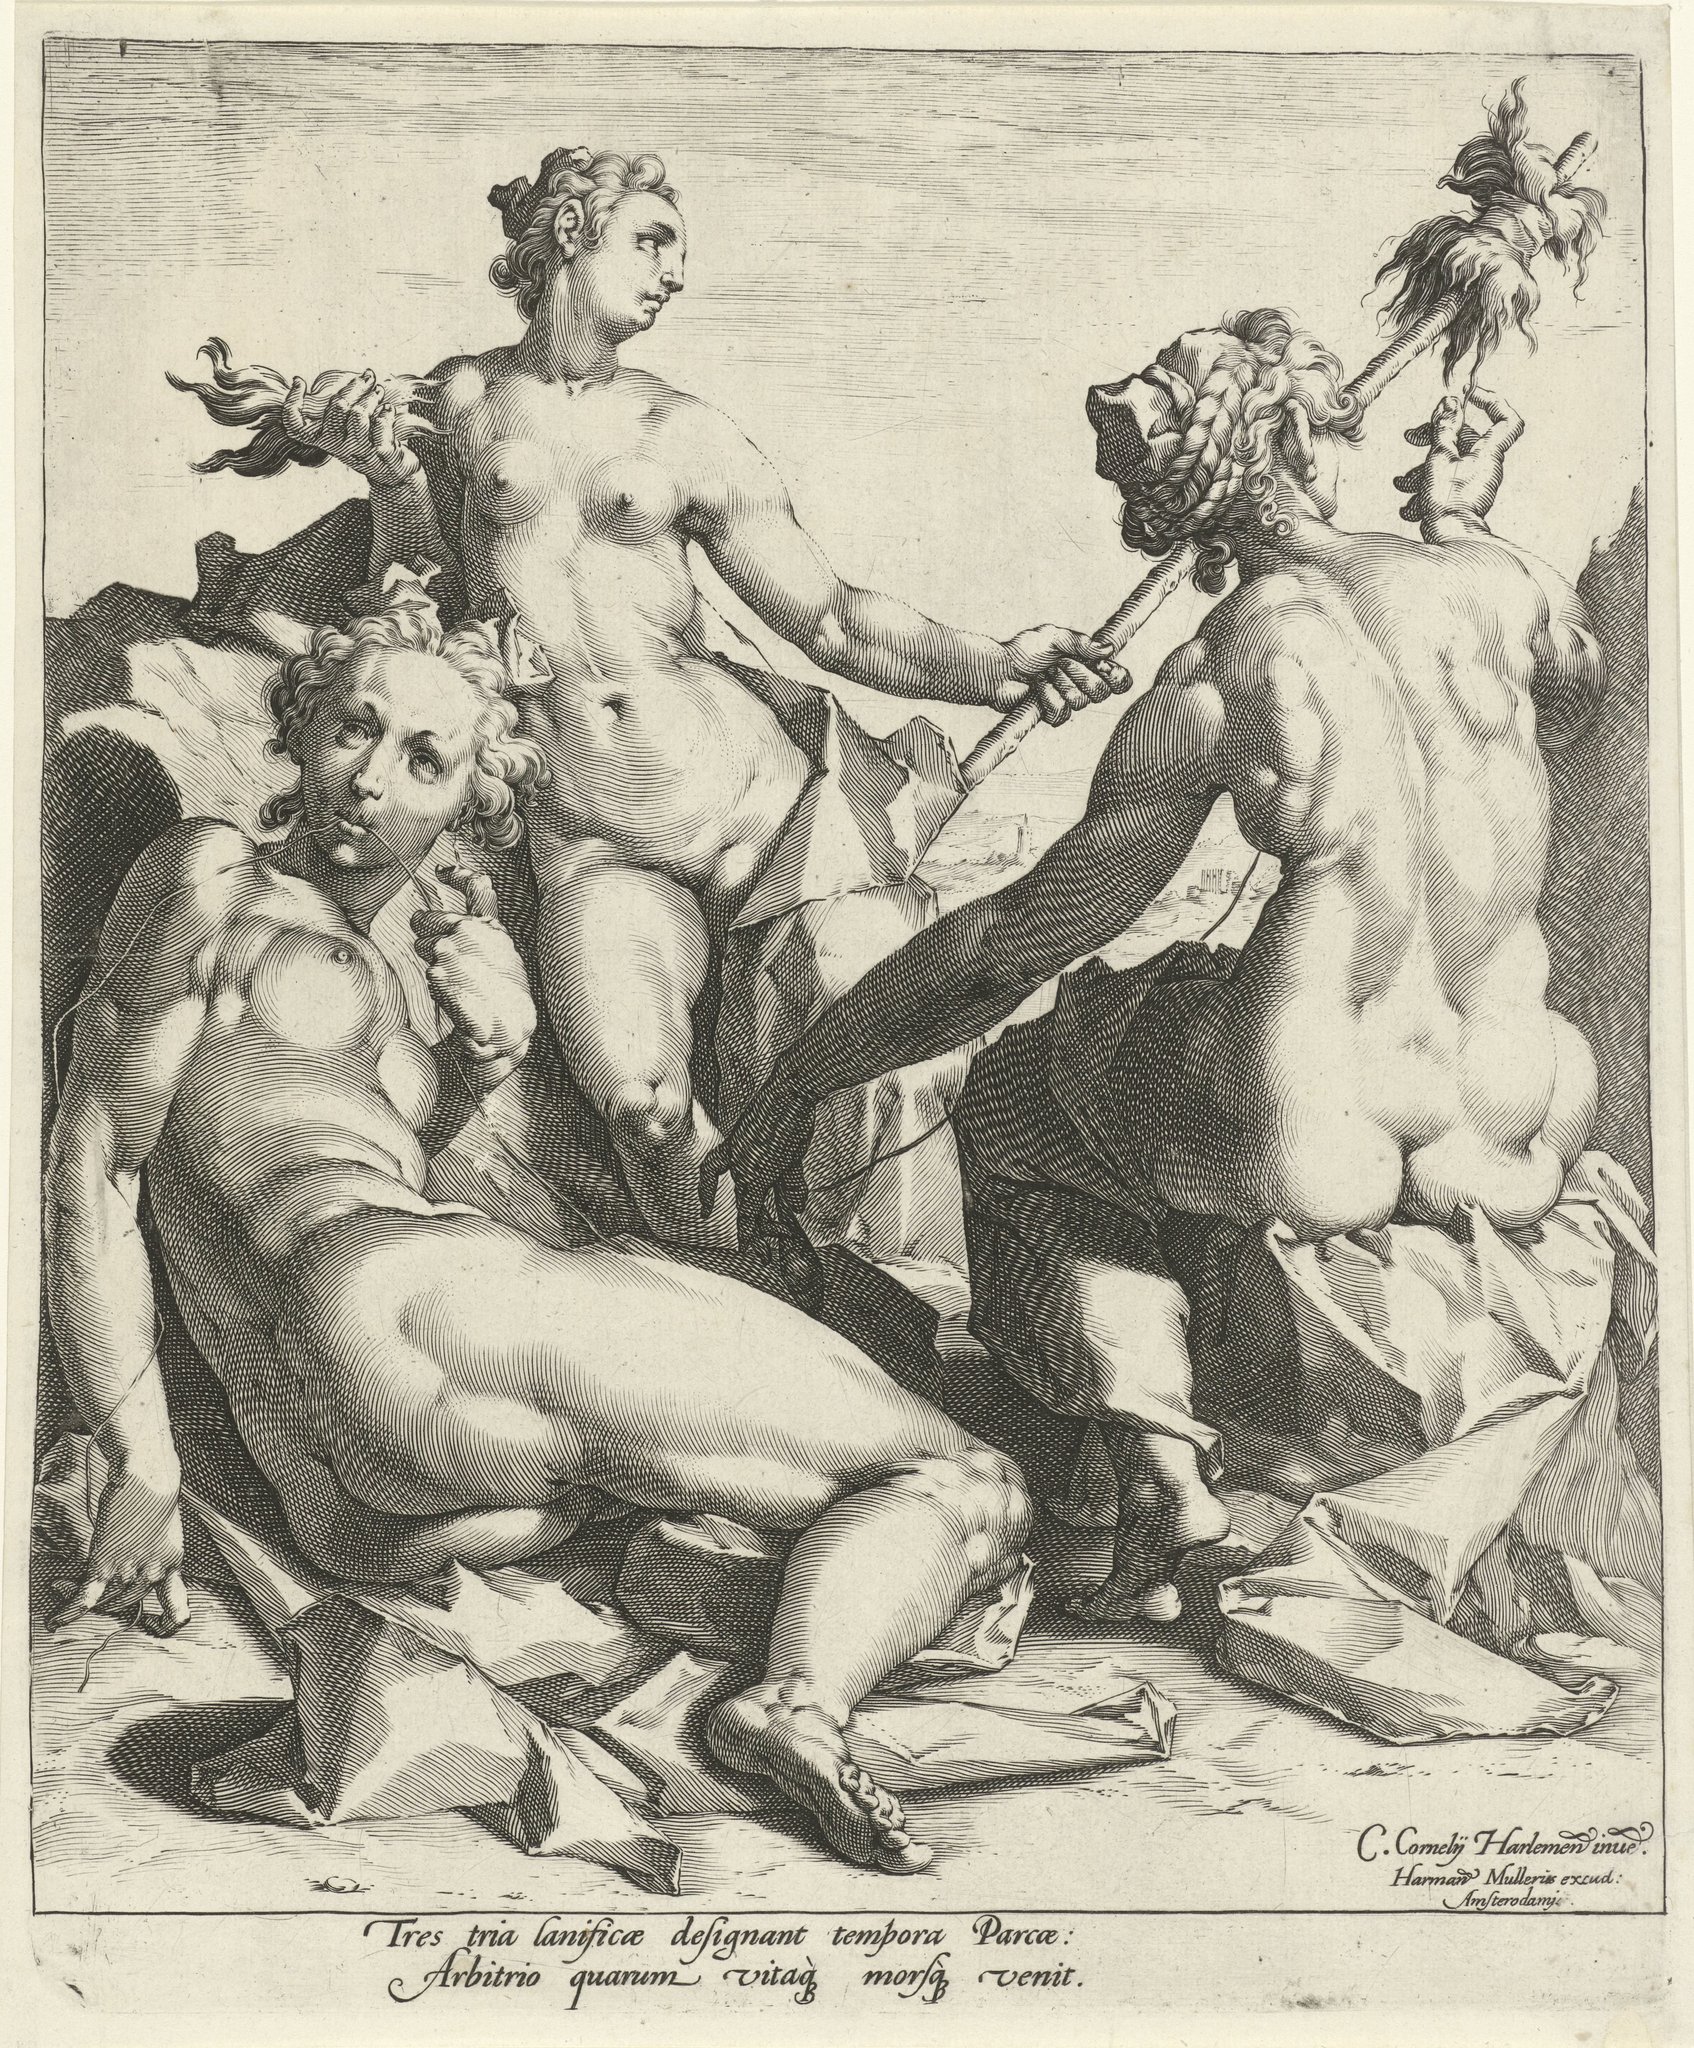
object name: print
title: Drie schikgodinnen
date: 1587-1591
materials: paper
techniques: engraving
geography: amsterdam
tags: fates, parcae (moirae)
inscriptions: collector's mark: Lugt 240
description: De drie schikgodinnen spinnen de levensdraad en bepalen de lengte en het einde van de draad. Clotho houdt in het midden de spinrok vast, Lachesis spint de draad en Atropos bijt met haar tanden de draad door. Onderaan in de marge twee regels in het Latijn.